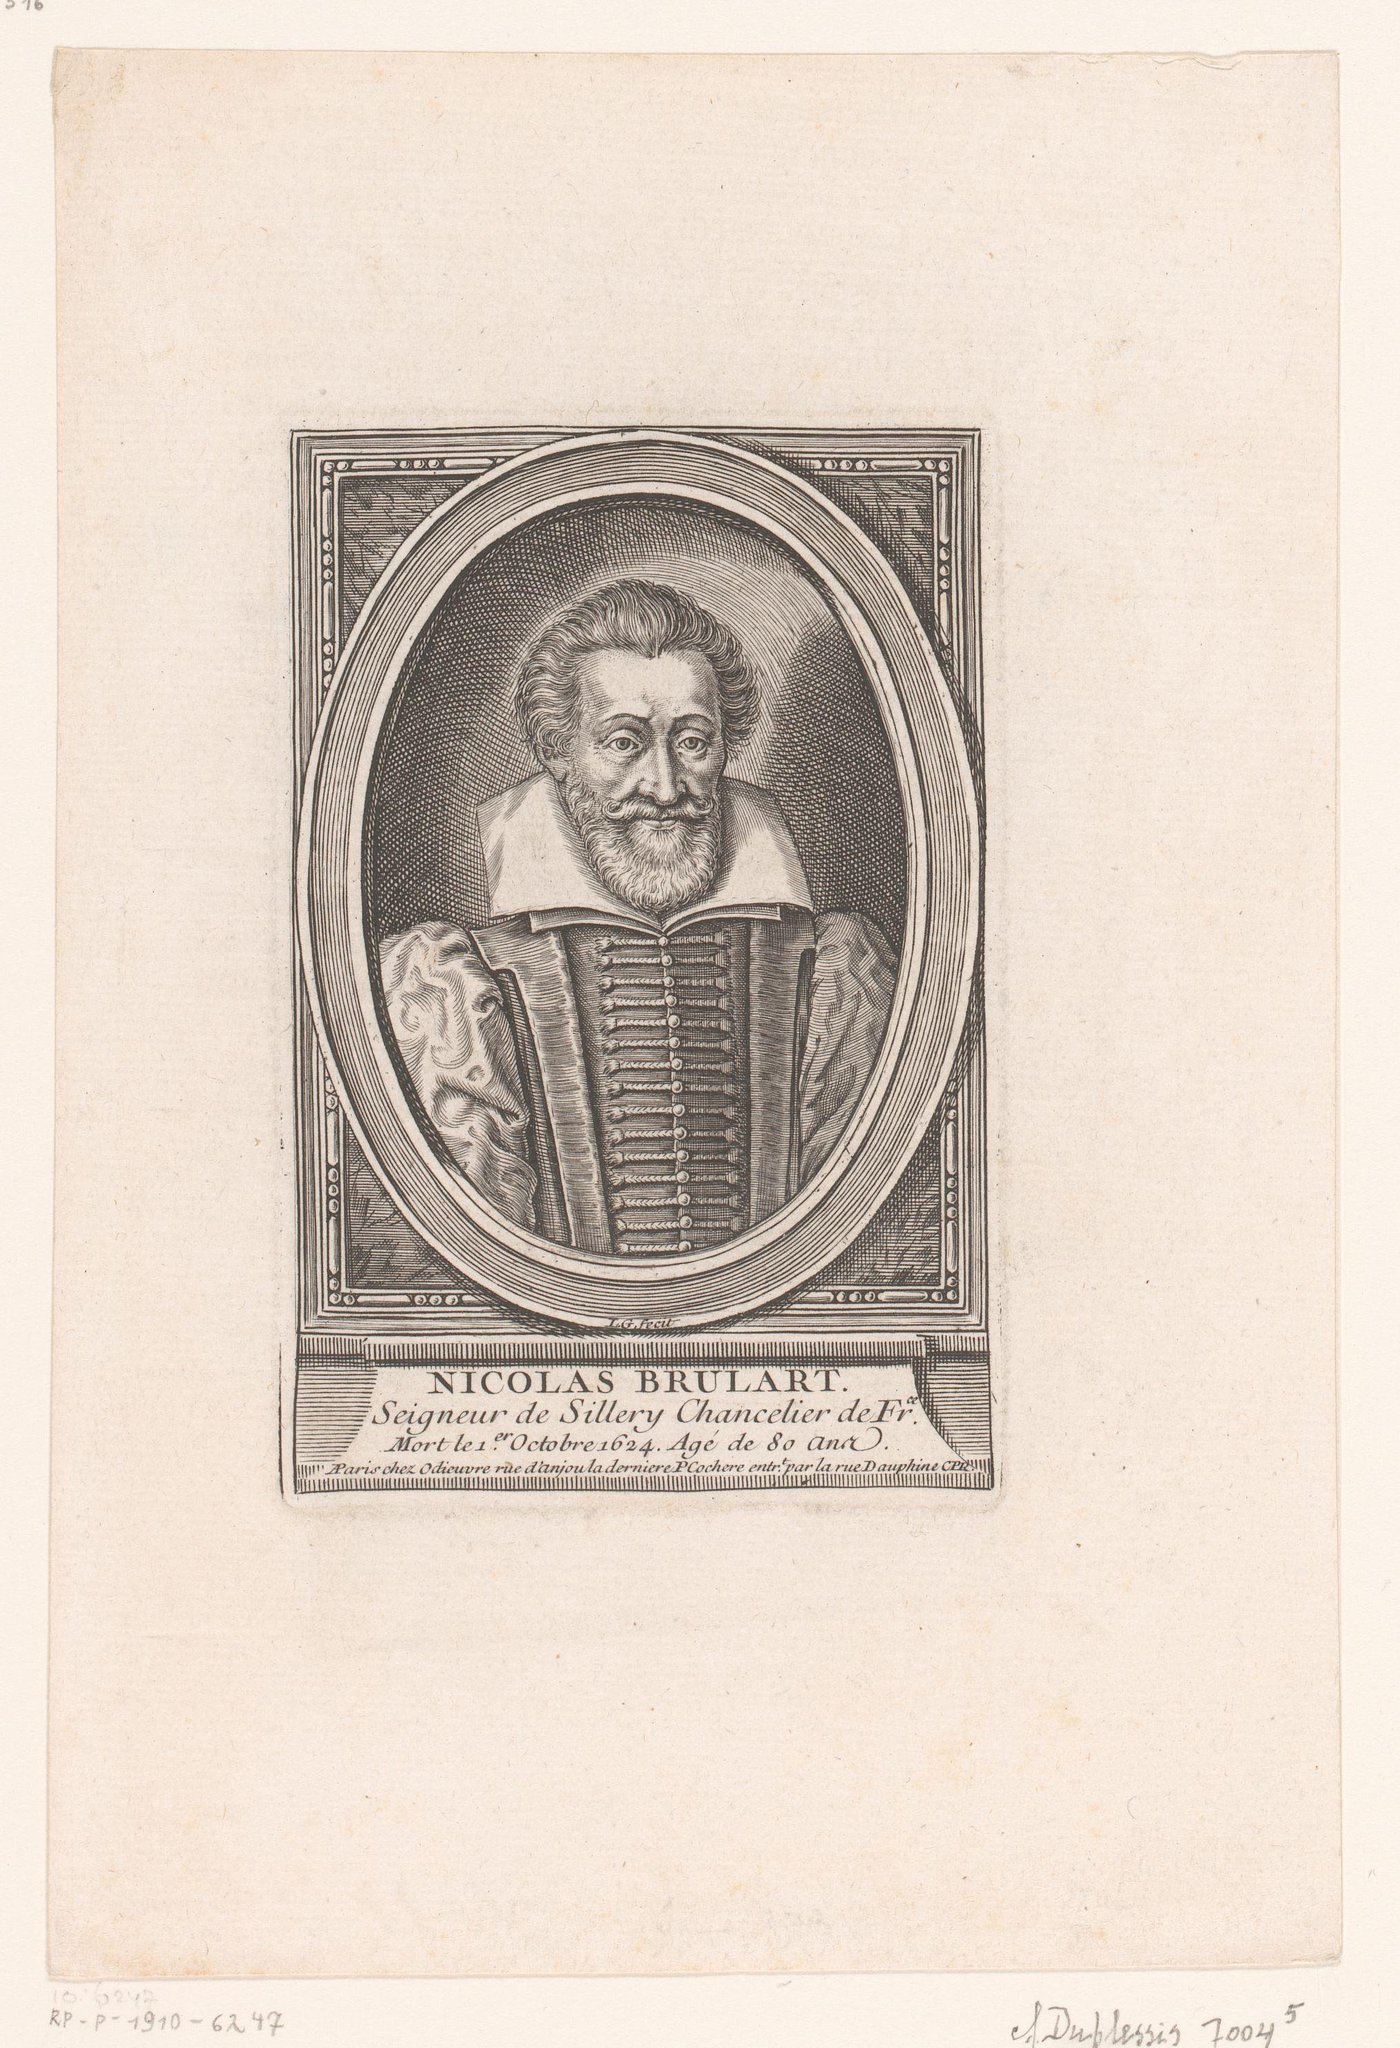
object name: print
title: Nicolas Brulart.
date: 1624-1641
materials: paper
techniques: engraving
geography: paris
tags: ornament ~ medallion, historical persons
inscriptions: collector's mark: Lugt 2228